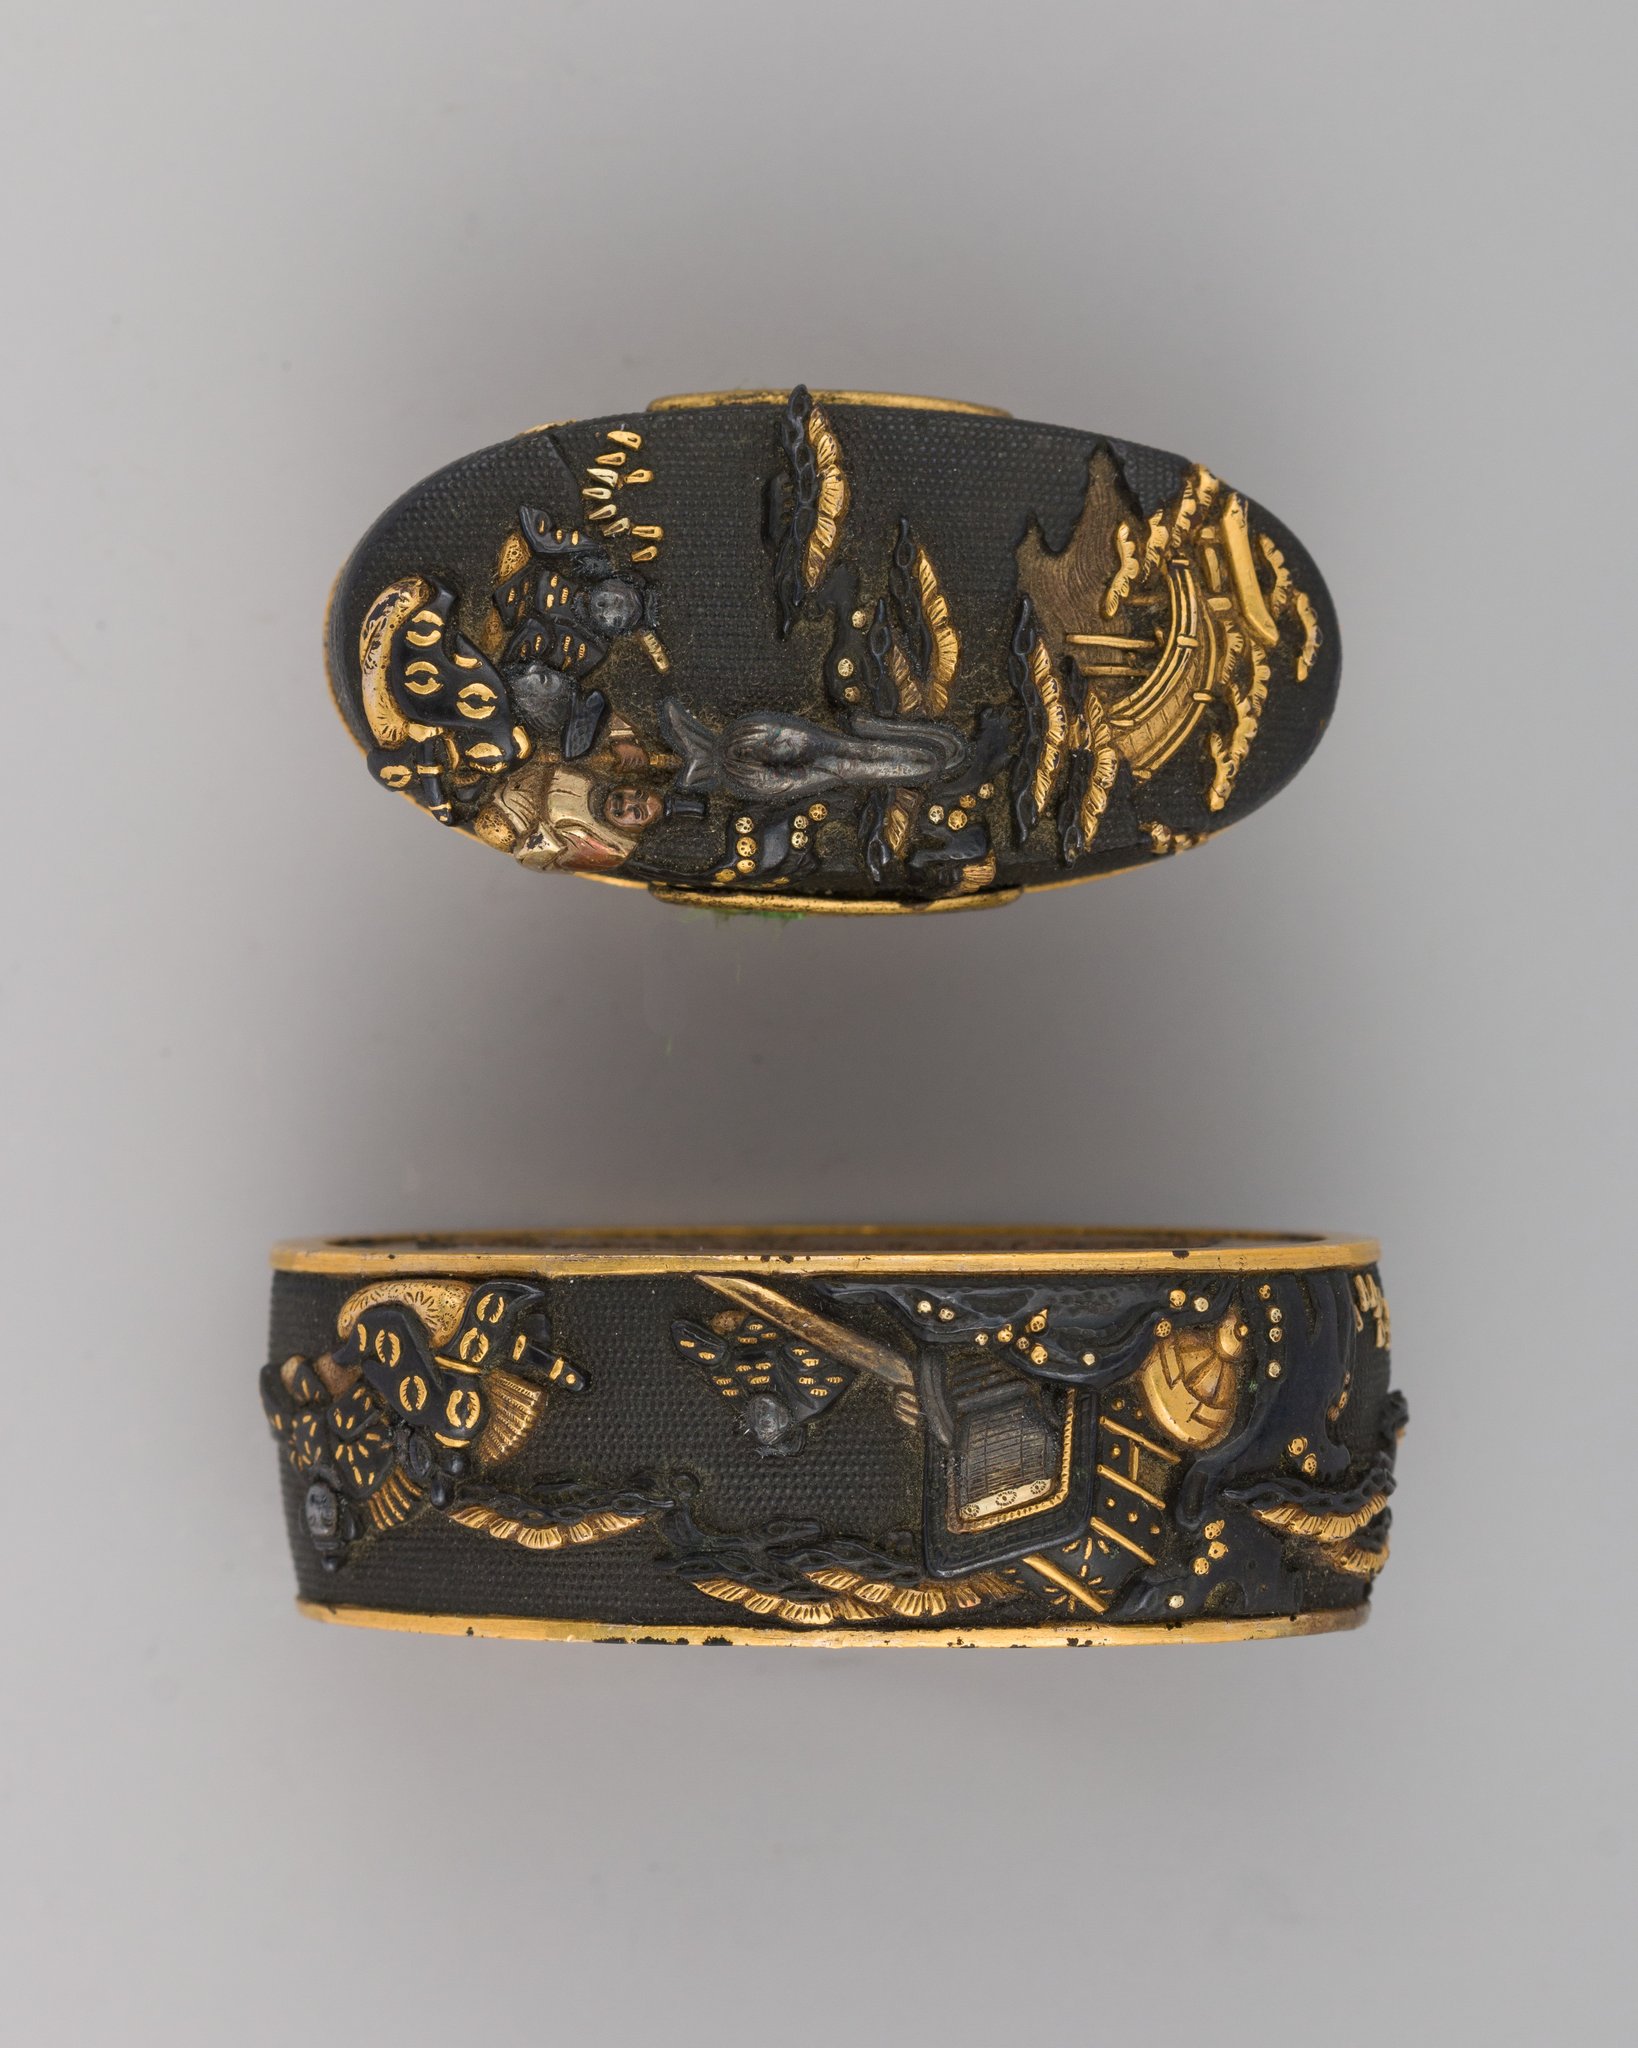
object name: sword hilt collar and pommel fuchigashira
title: Sword-Hilt Collar and Pommel (Fuchigashira)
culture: japanese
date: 1701-1800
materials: gold alloy, gold, silver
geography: japan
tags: men